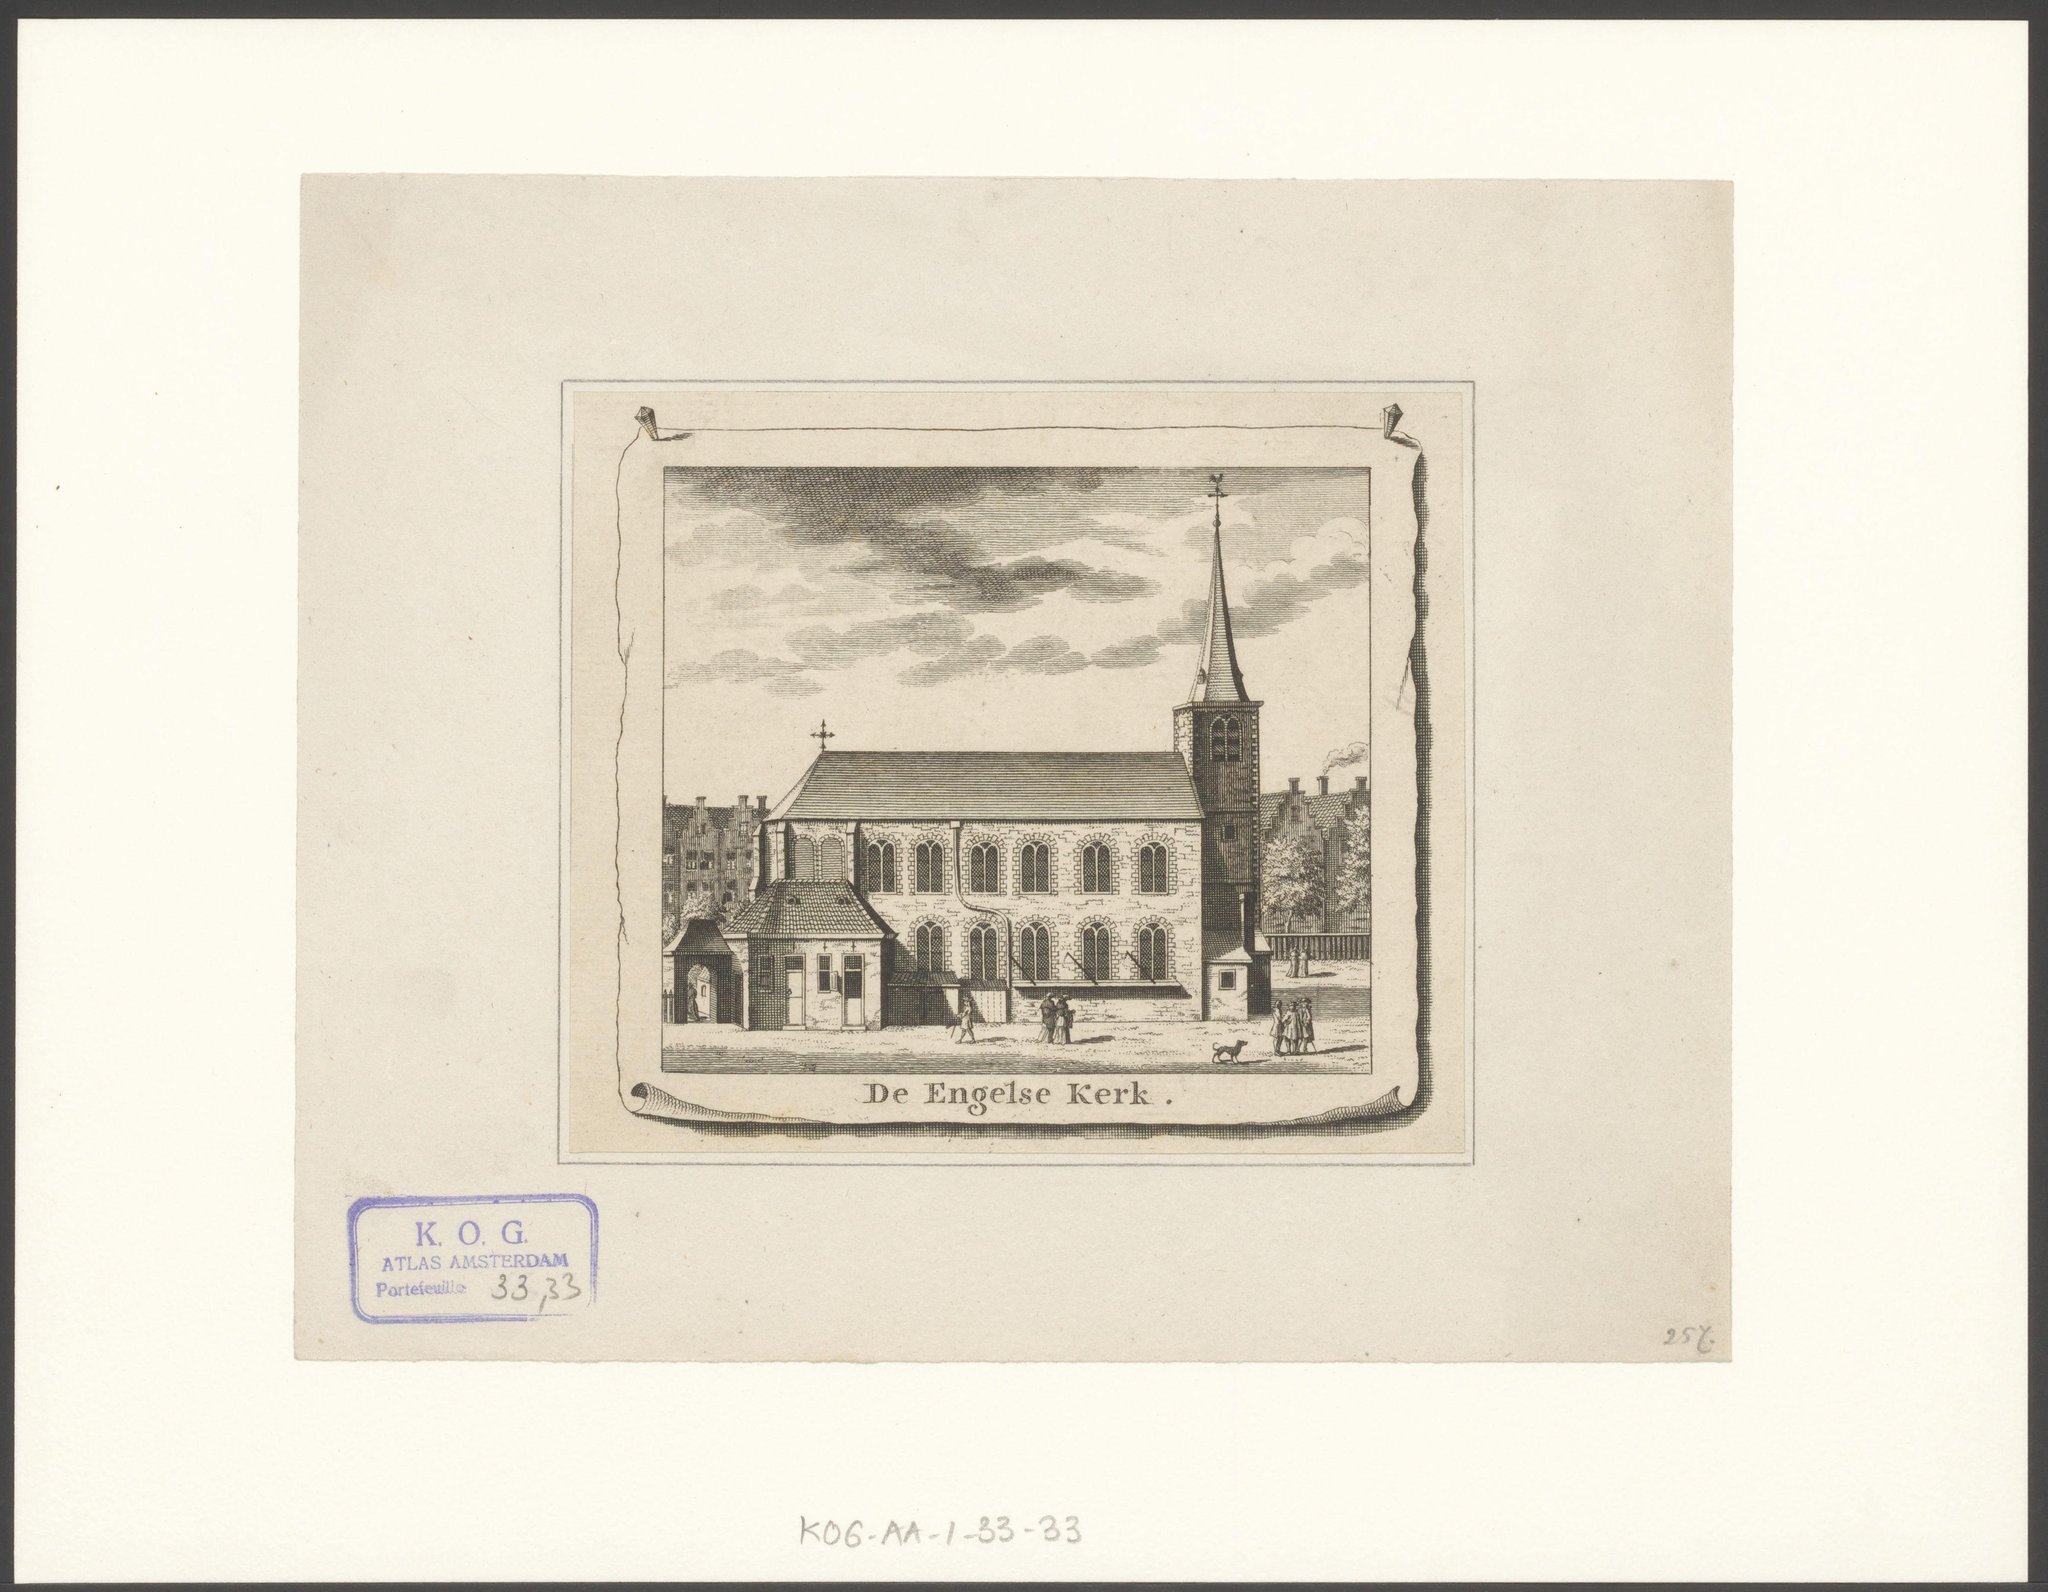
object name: print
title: De Engelse Kerk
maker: daniël stopendaal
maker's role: print maker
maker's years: 1672-1726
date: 1685-1726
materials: paper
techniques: engraving, etching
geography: amsterdam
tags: church (exterior)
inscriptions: collector's mark: Lugt 1641b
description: Onderwerpsrubriek binnen de Atlas Amsterdam: Kerkwezen: Hervormde Gemeente: Engelse Hervormde Gemeente.